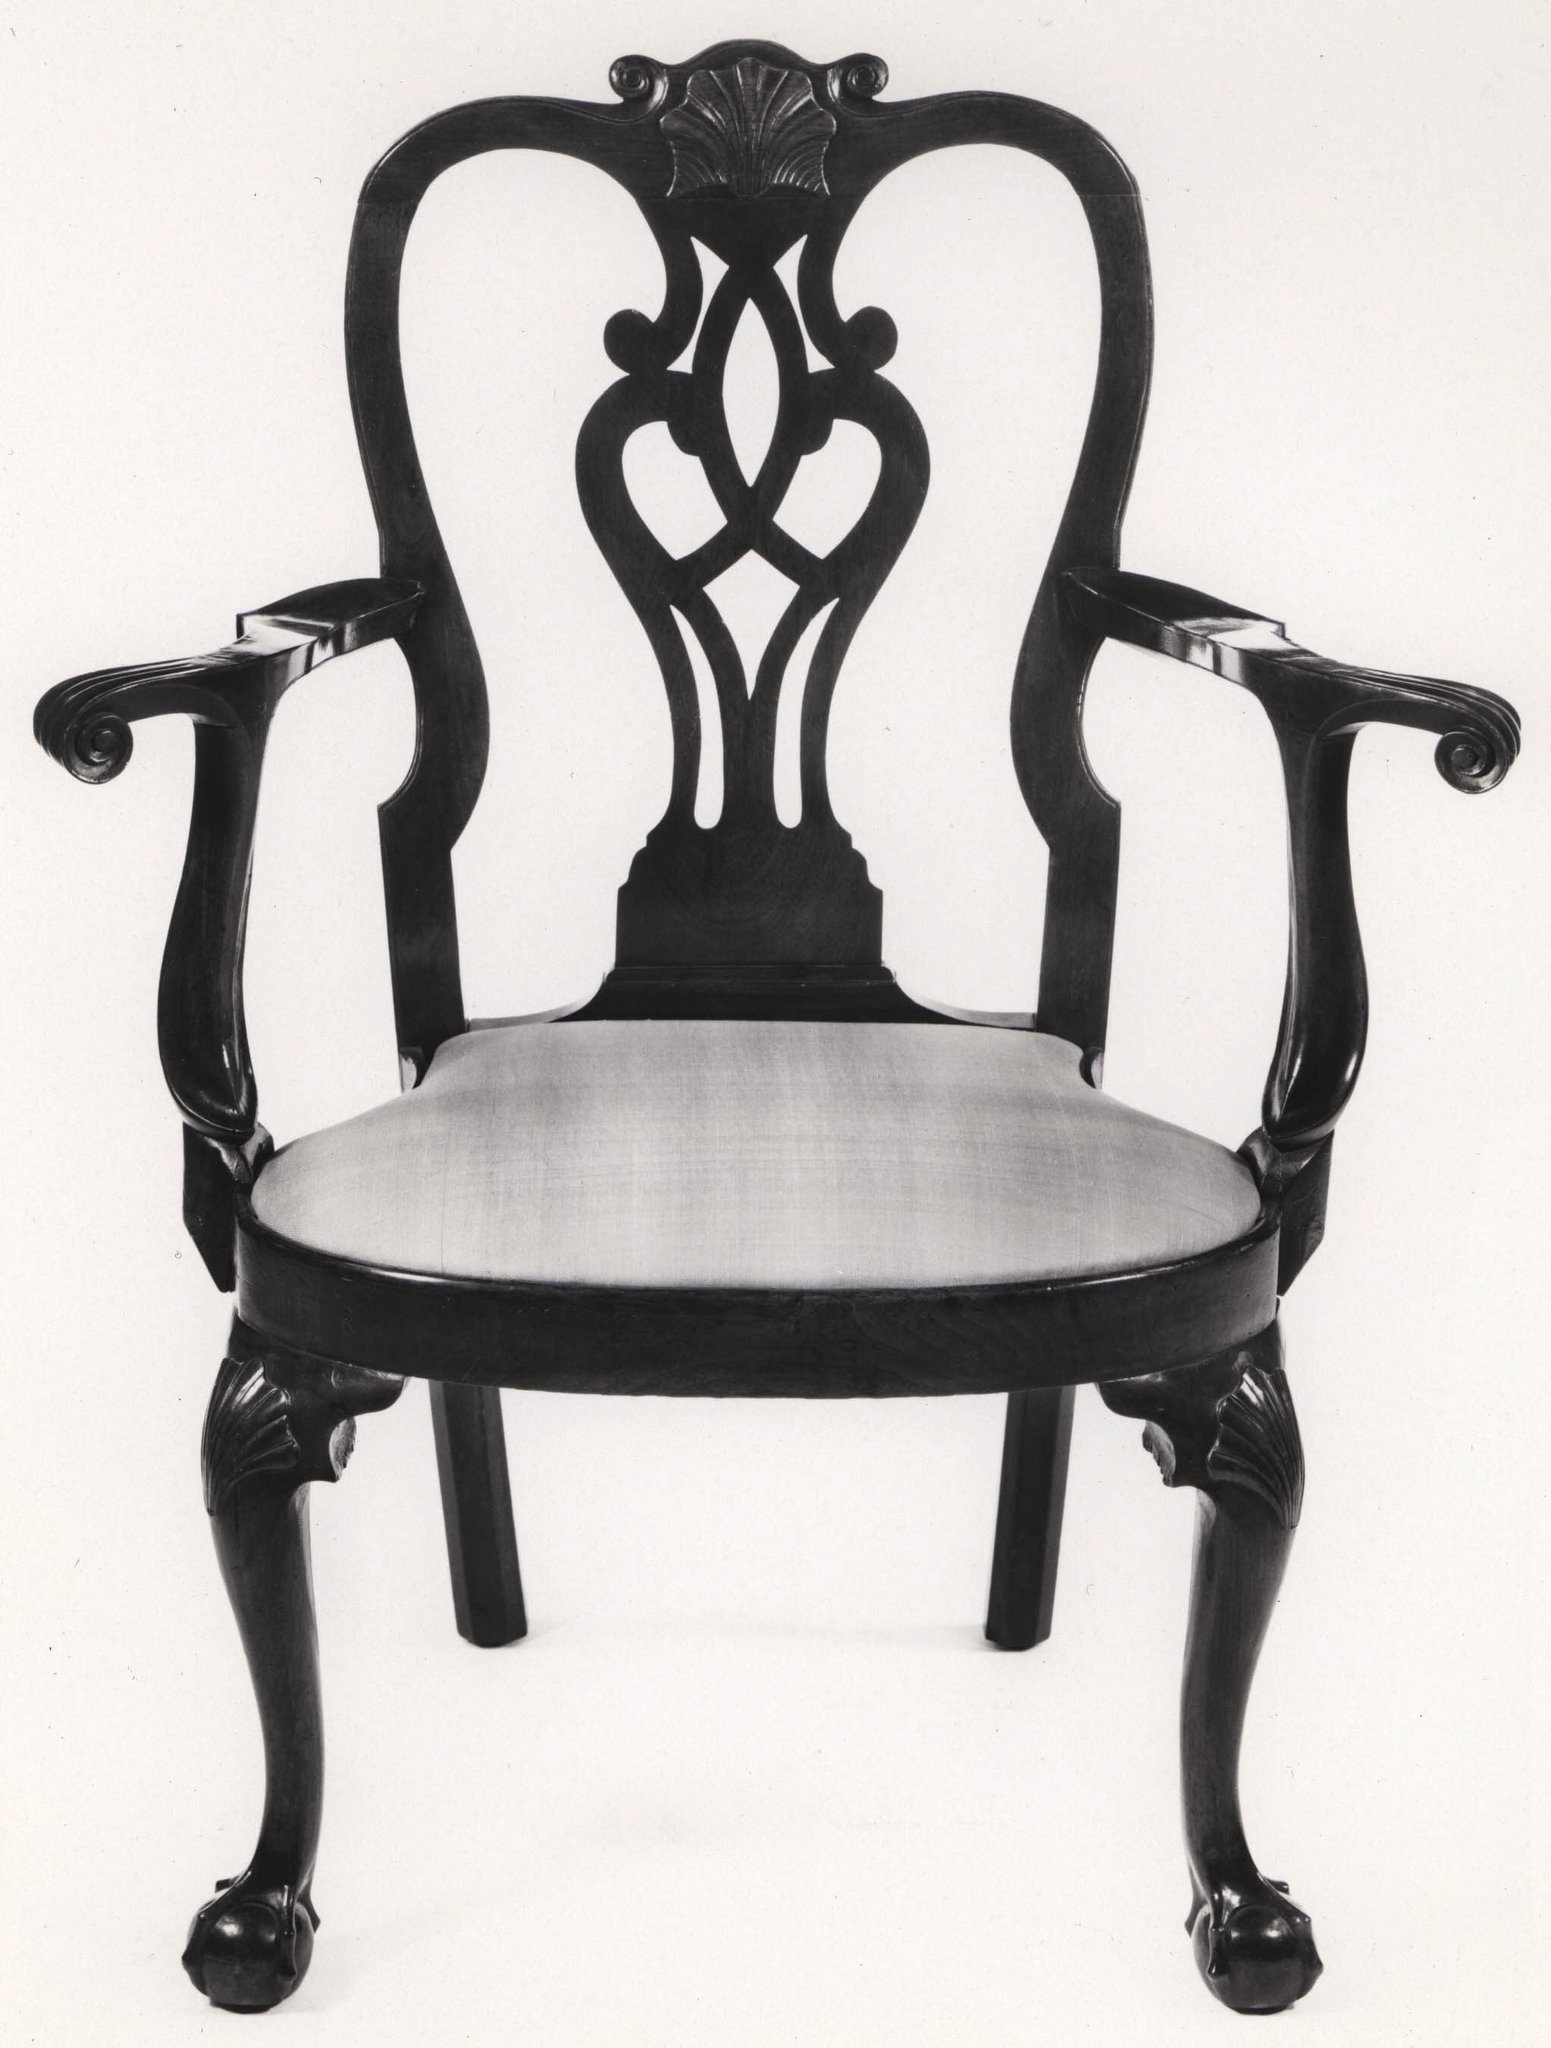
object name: armchair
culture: american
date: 1750-1765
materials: wood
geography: united states